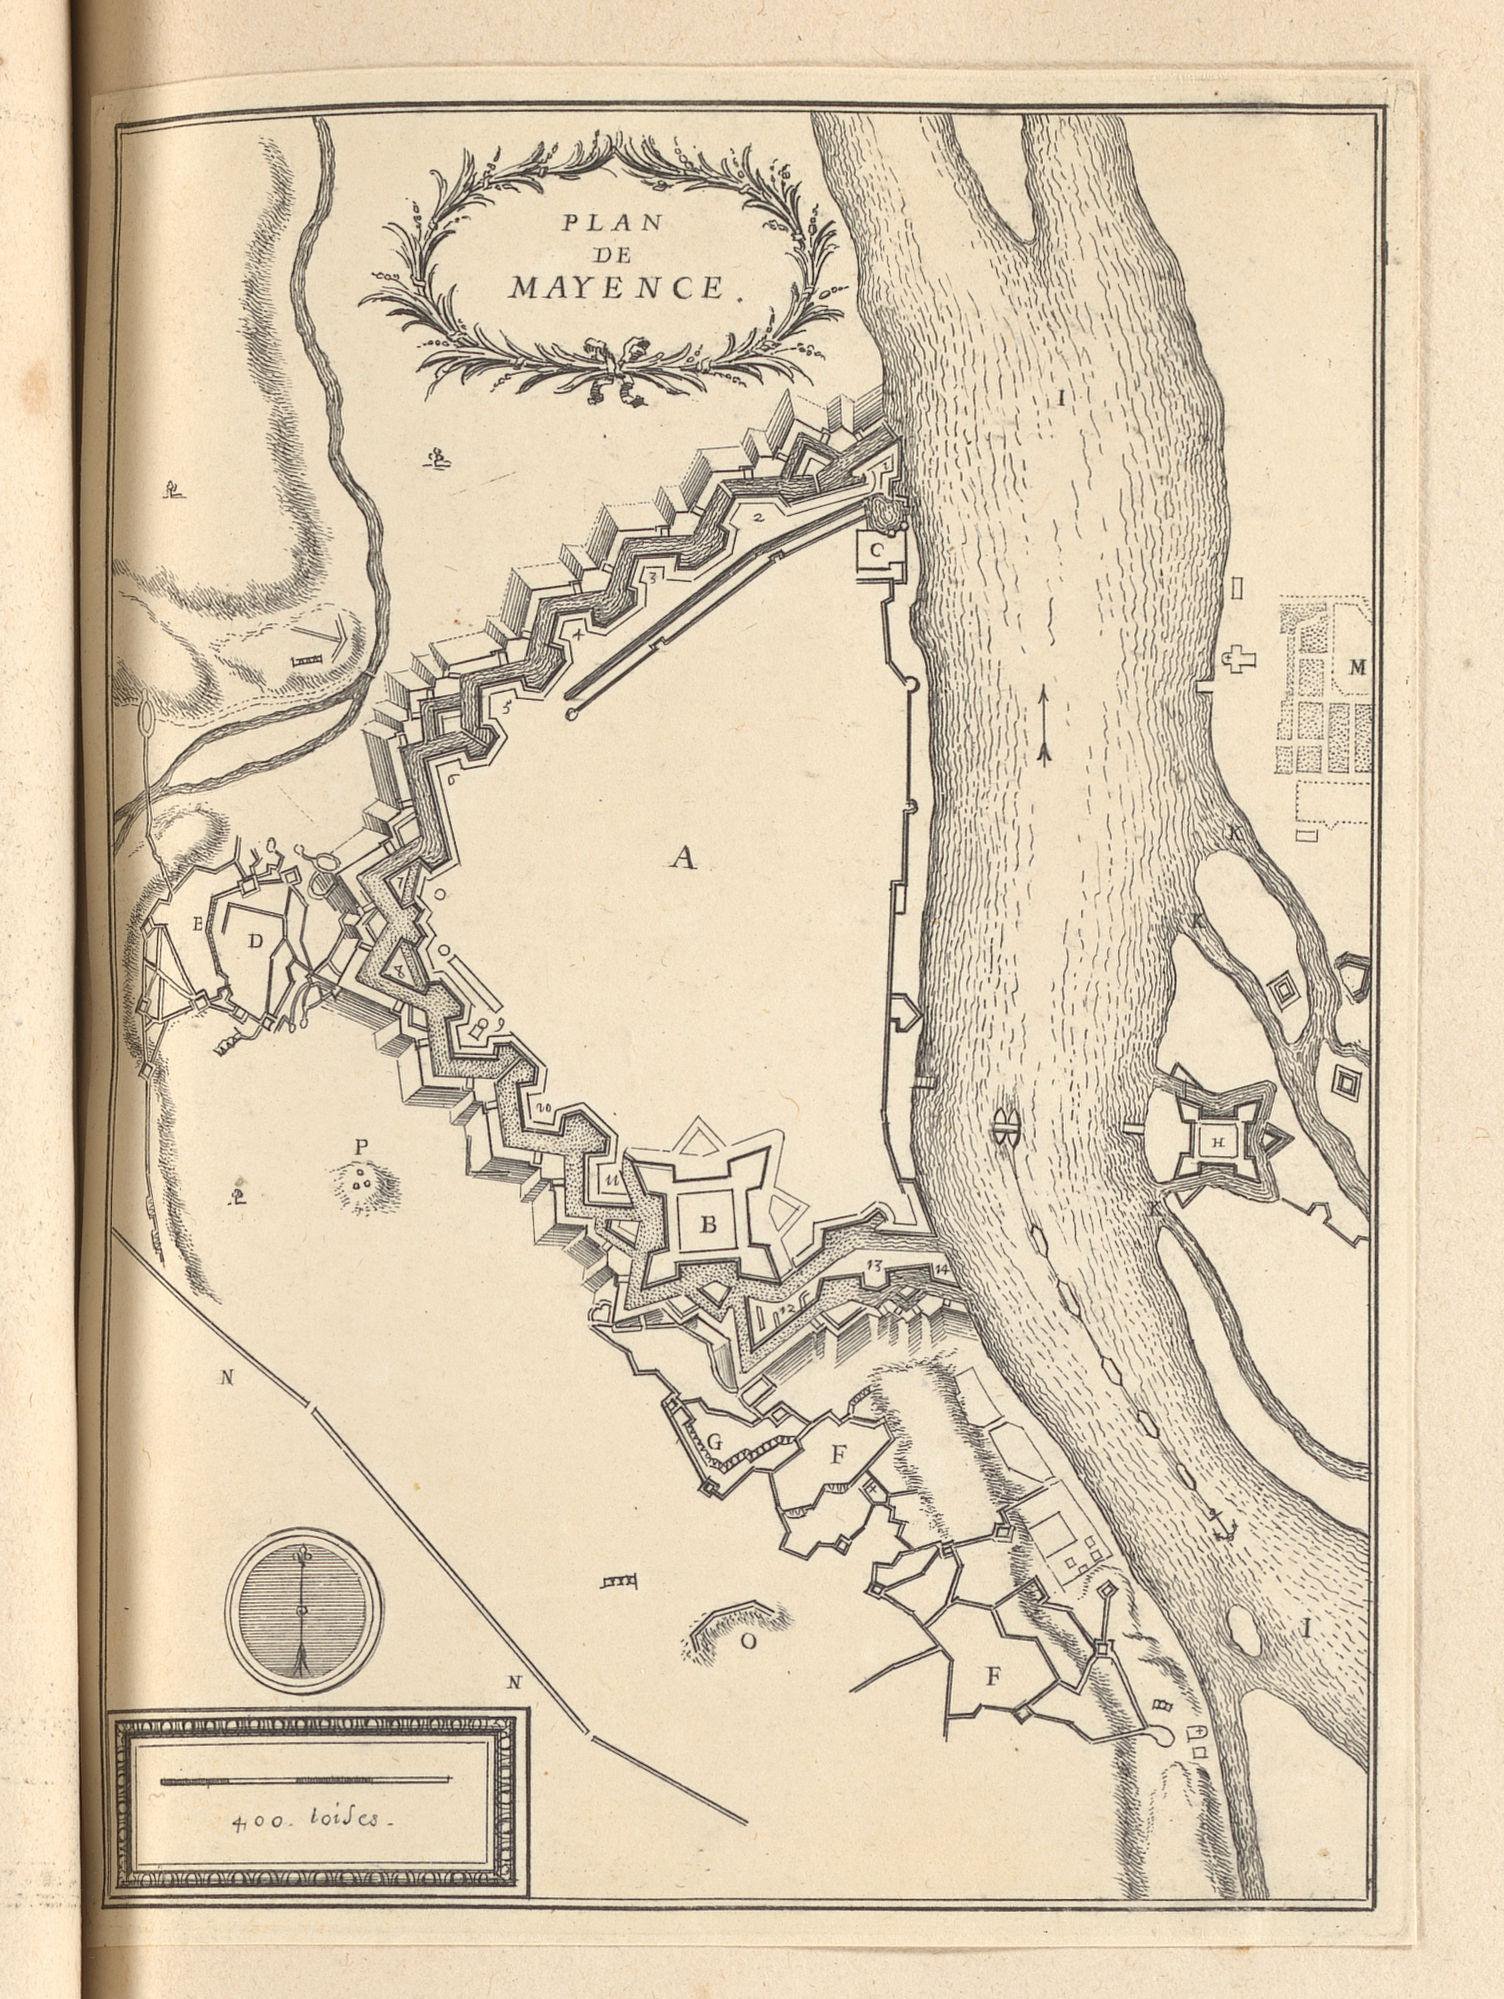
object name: album leaf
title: Histoire de Charles V duc de Lorraine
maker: sébastien leclerc (i)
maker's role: print maker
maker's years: 1637-1714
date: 1704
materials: paper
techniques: etching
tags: maps of cities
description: Prent maakt deel uit van een serie met 37 prenten van veldslagen waaraan Karel V Leopold, hertog van Lotharingen, heeft deelgenomen.